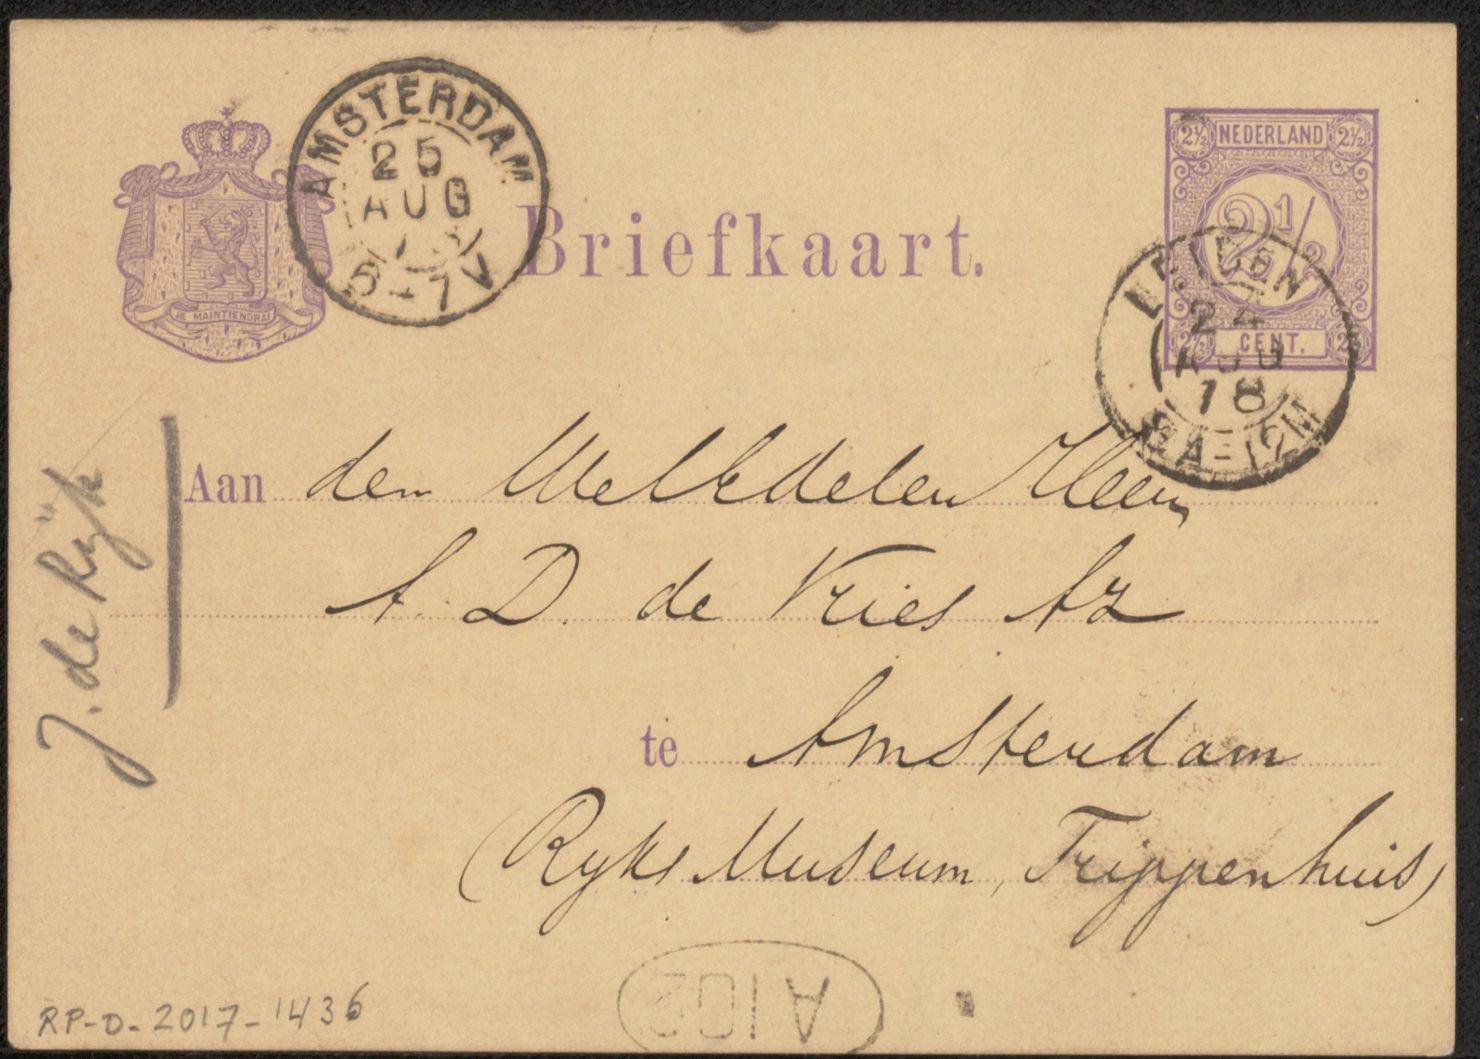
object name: postcard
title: Briefkaart aan Adrianus Daniël de Vries Azn.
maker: p.a. tiele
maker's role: auteur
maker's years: 1834-1889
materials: cardboard, ink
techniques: pen, writing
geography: leiden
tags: james de rijk, print maker, draughtsman, jacobus ludovicus cornet, amsterdam, leiden, publisher, johannes tiberius bodel nijenhuis, drawing, the graphic arts